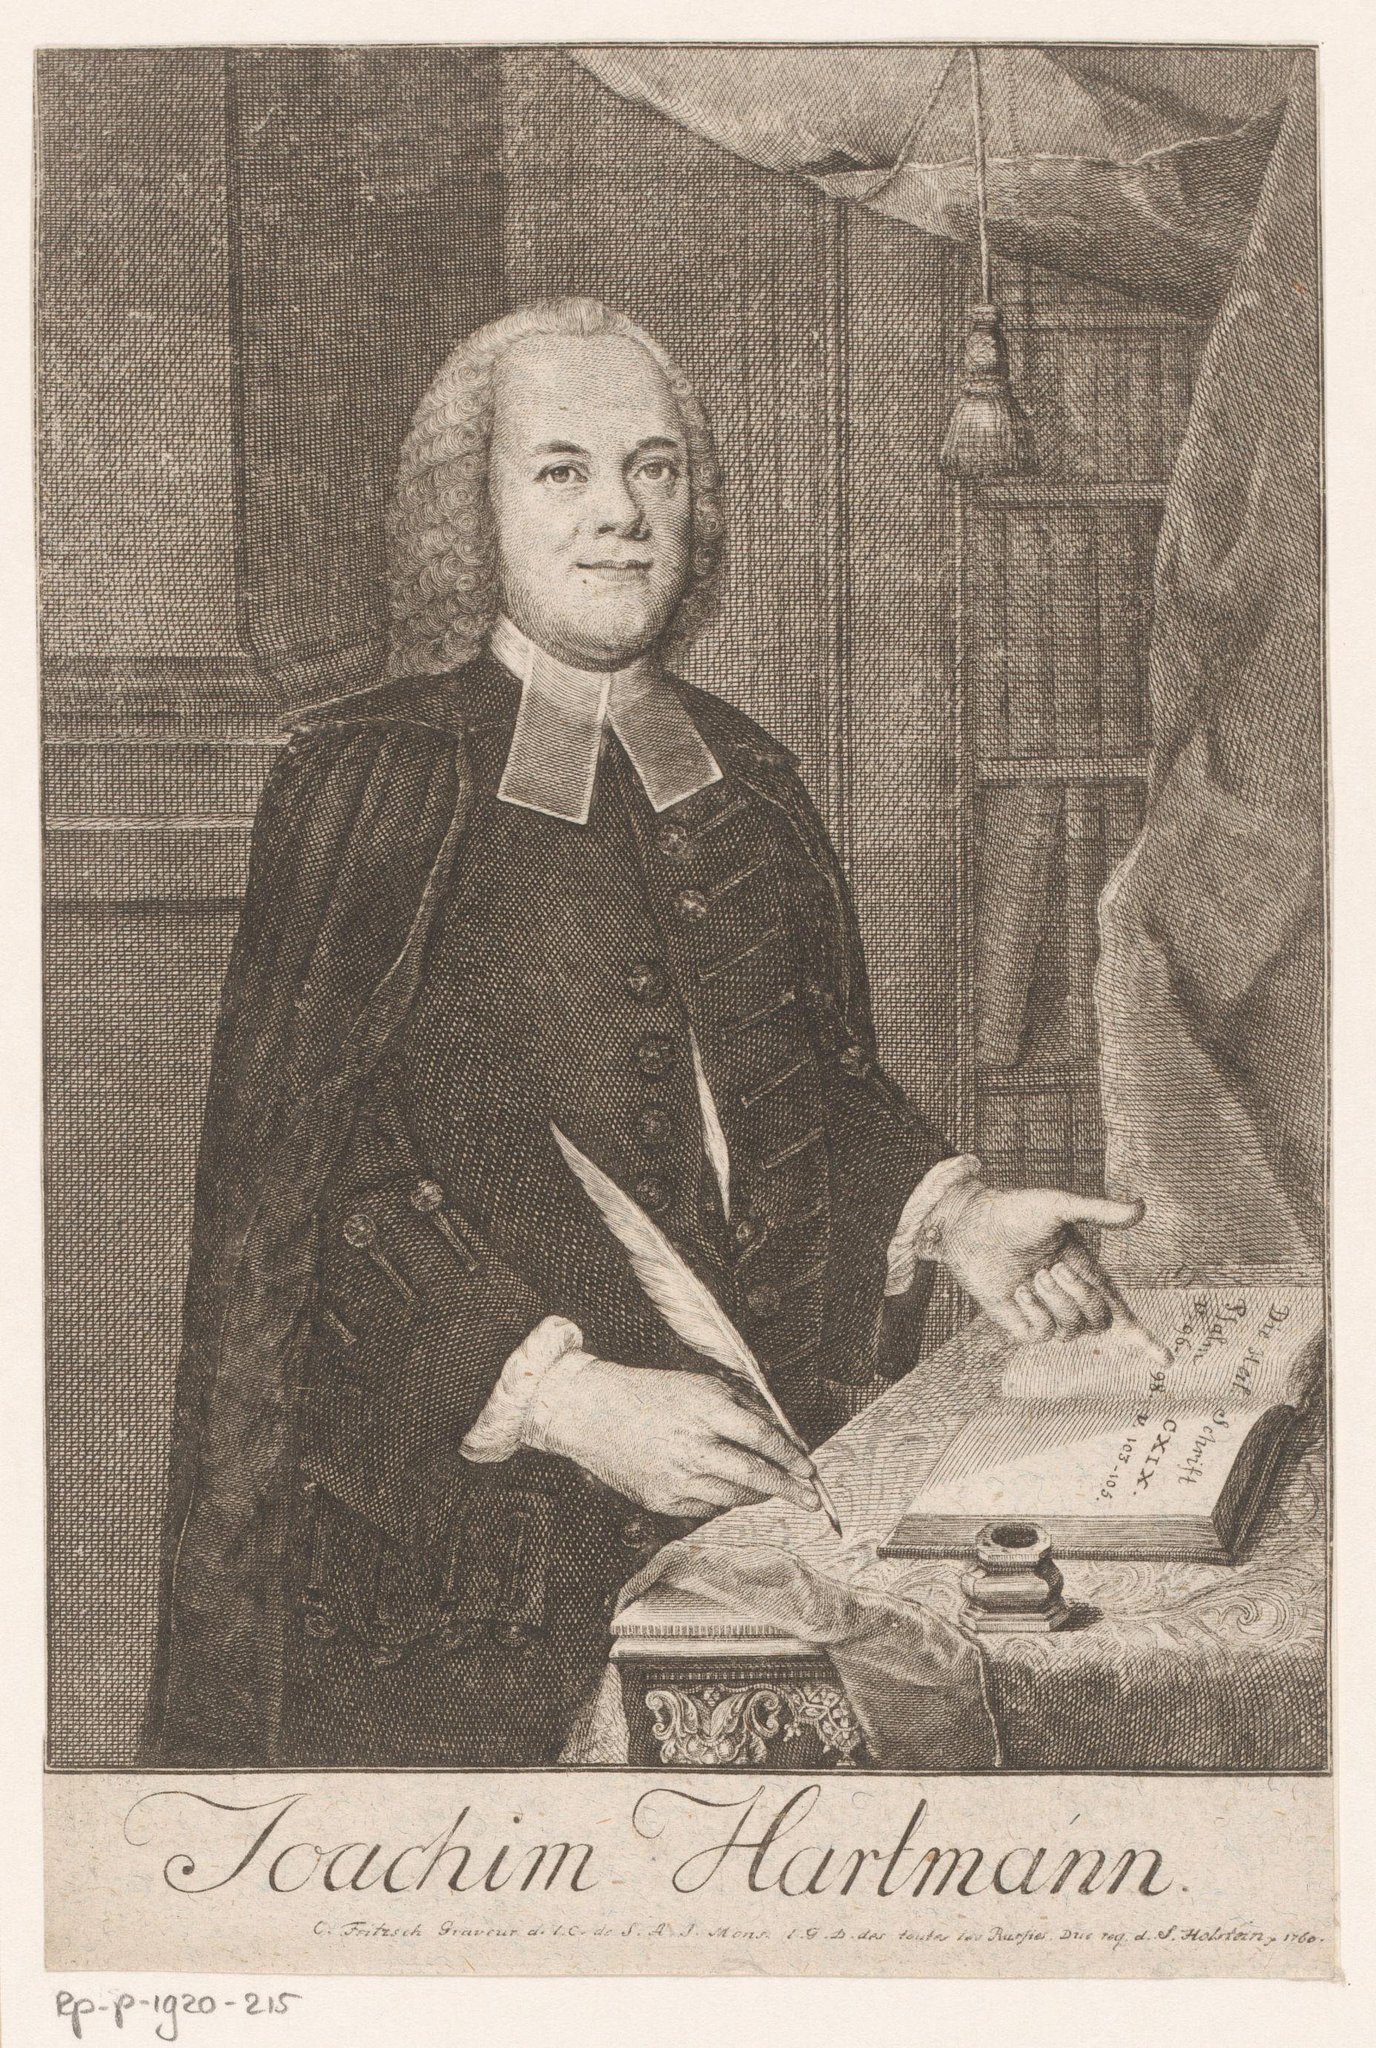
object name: print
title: Portret van Joachim Hartmann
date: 1760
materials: paper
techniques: engraving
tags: bookshelves, writing tools, historical persons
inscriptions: collector's mark: Lugt 2228